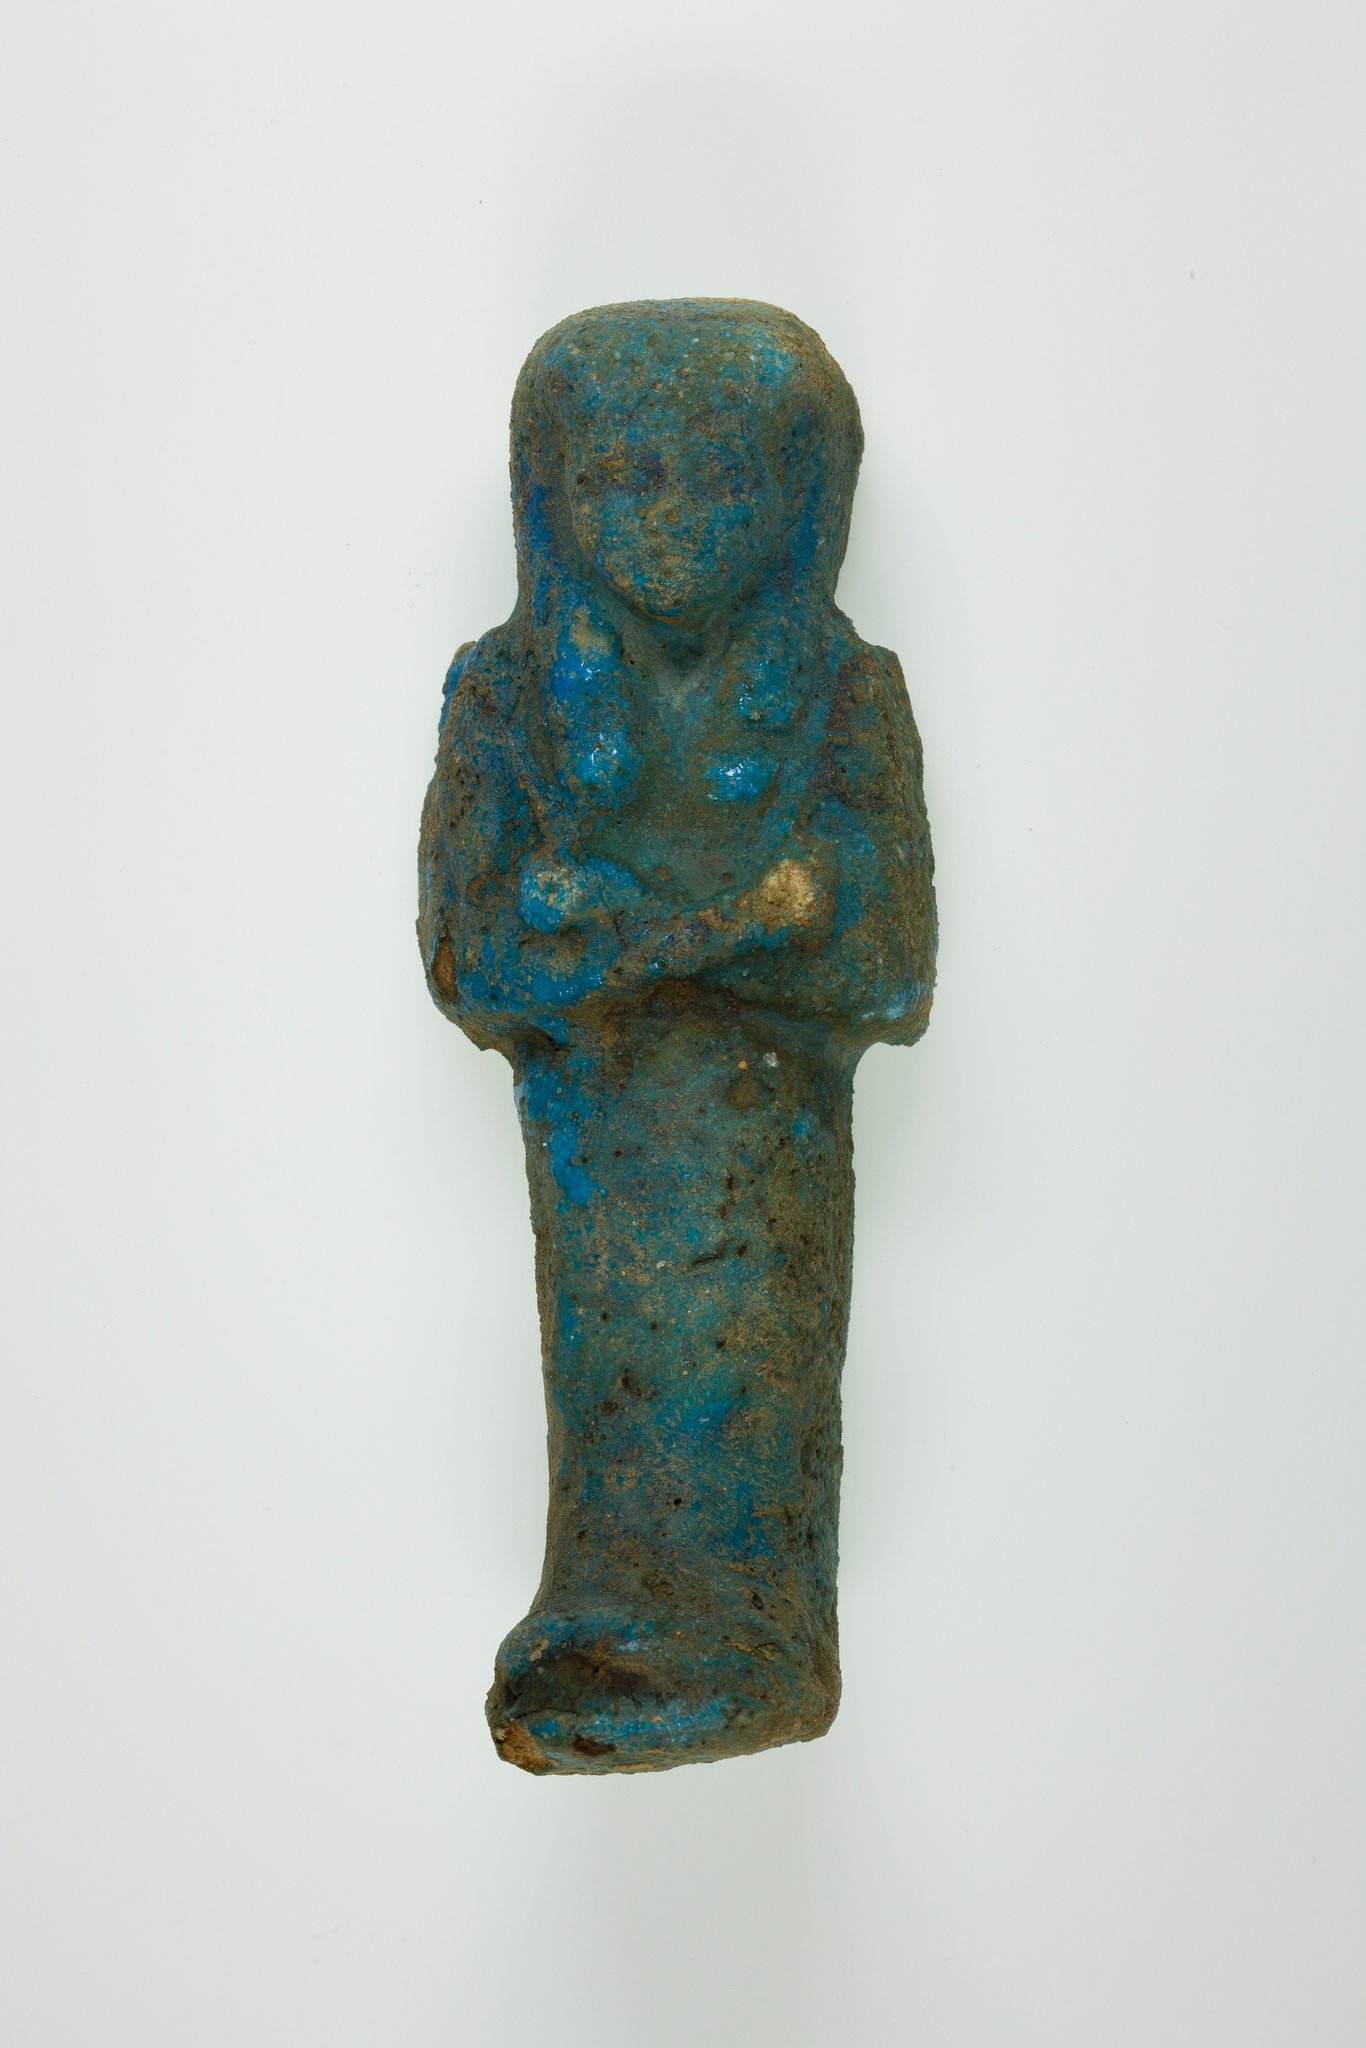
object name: worker shabti, henettawy c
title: Worker Shabti of Henettawy (C), Daughter of Isetemkheb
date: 990-970 BCE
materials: faience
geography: egypt